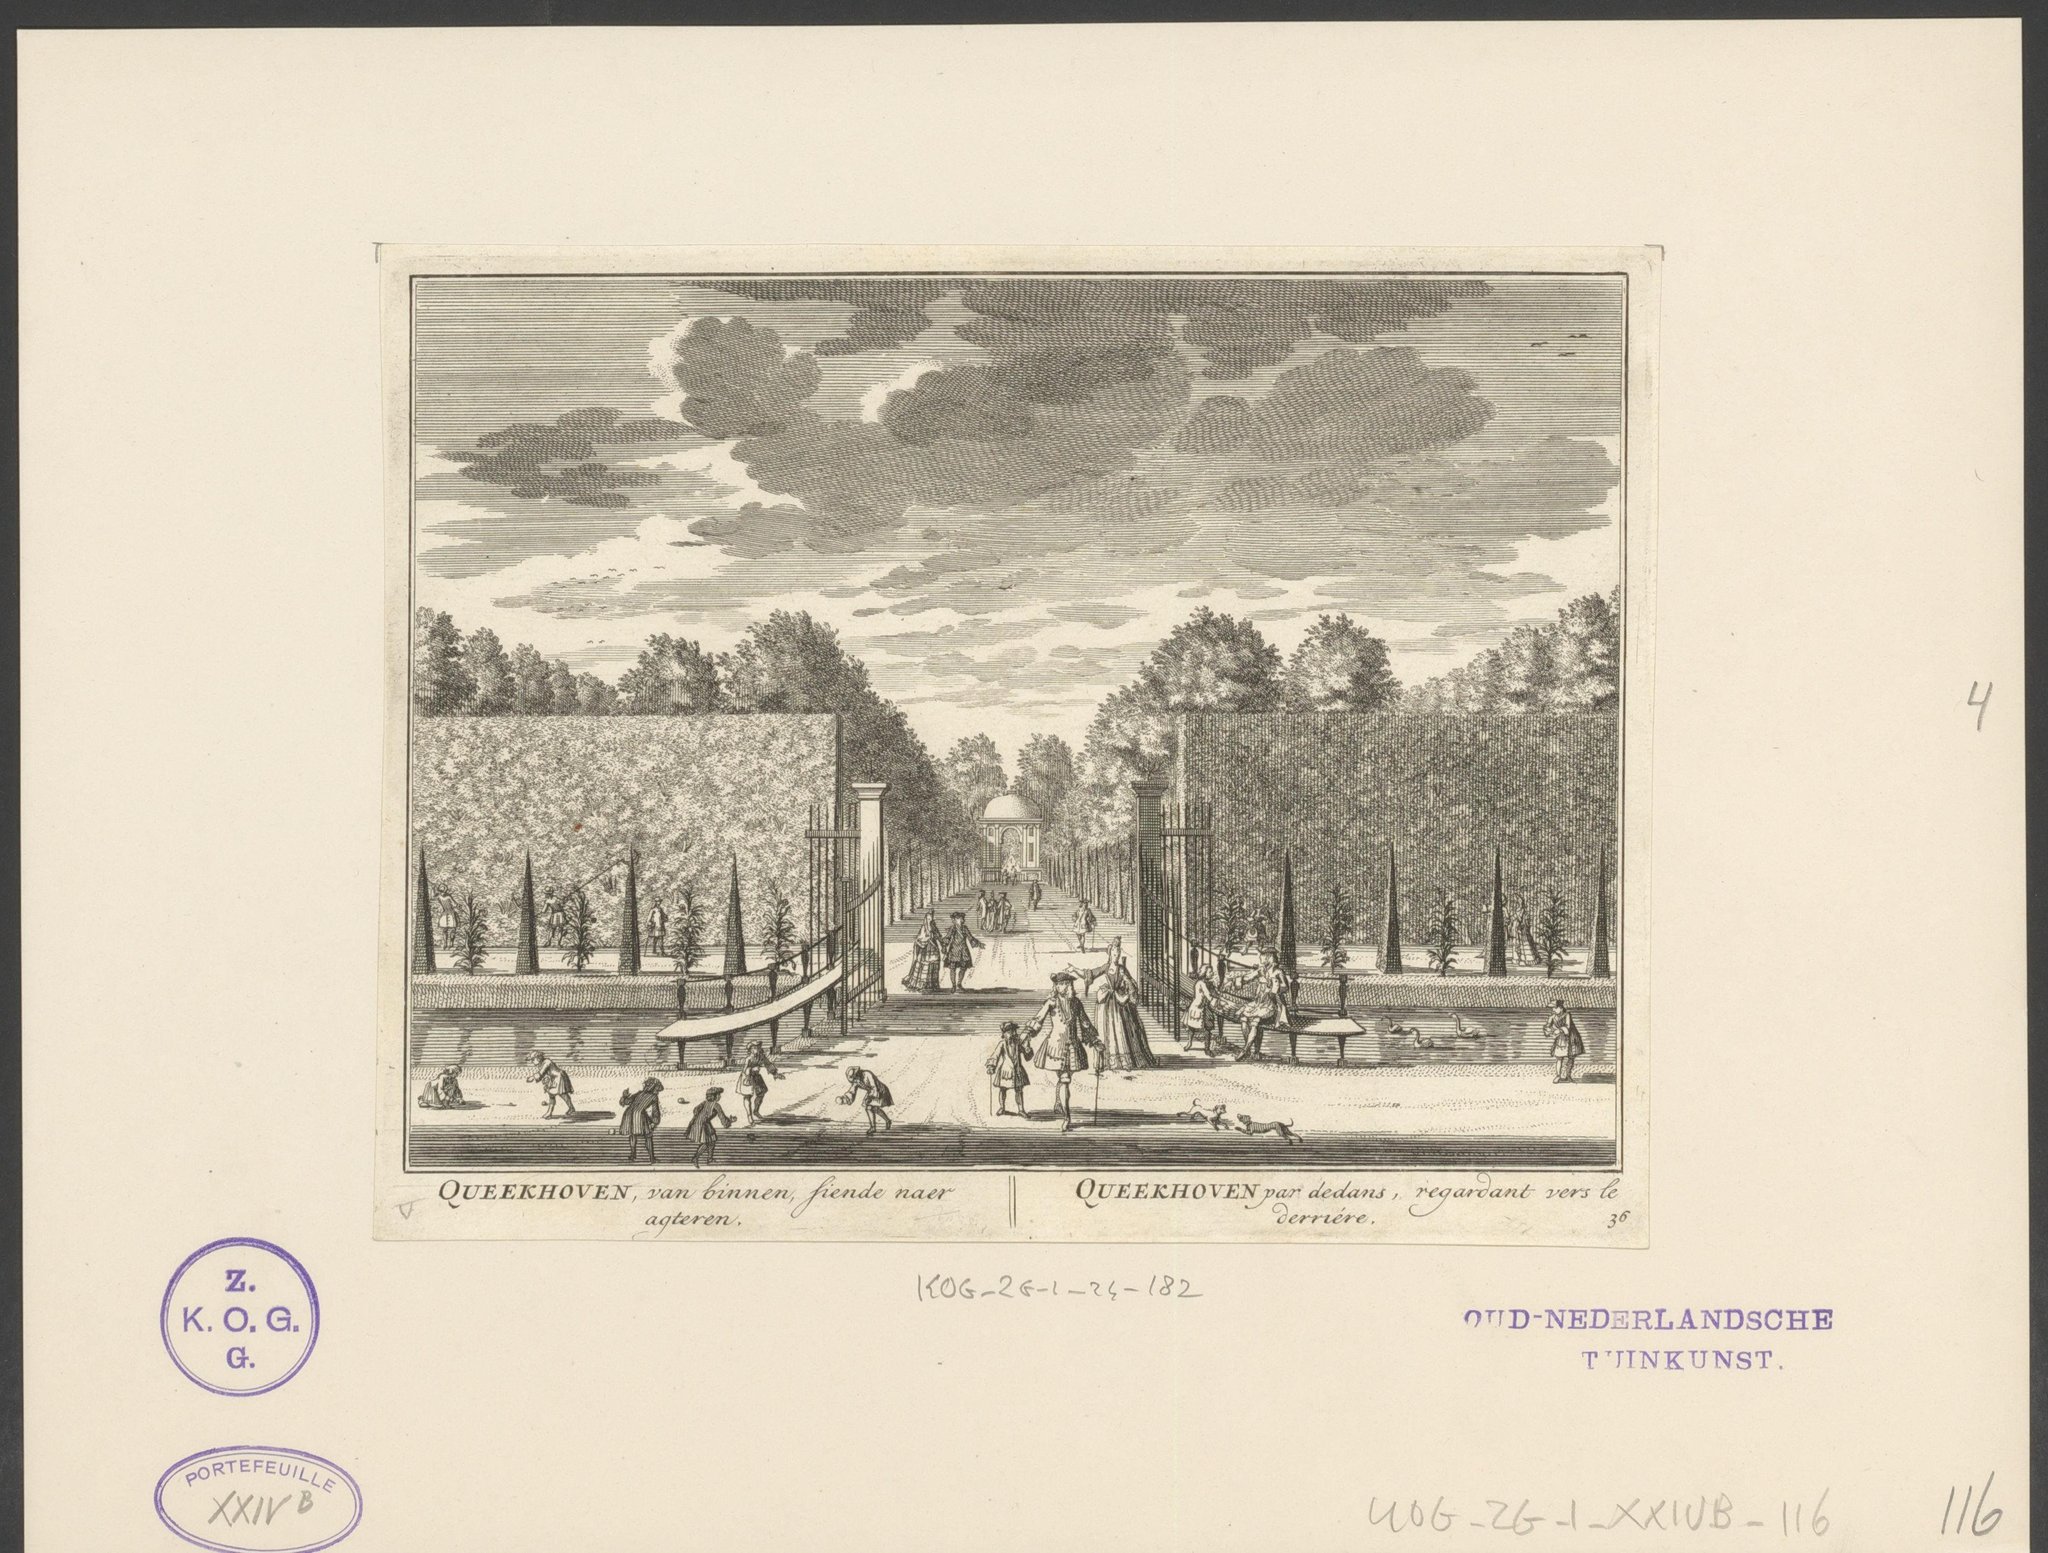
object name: print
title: Queekhoven, van binnen, siende naer agteren / Queekhoven par dedans, regardant vers le derriére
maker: hendrik de leth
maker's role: draughtsman, print maker, publisher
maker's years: 1703-1766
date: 1729-1732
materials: paper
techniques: engraving, etching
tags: french or architectonic garden; formal garden, forest path or lane, country-house, vecht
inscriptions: stamp, stamp, collector's mark: Lugt 1641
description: Prent mogelijk uit: Brouërius van Nidek, Matthaeus. Het zegepralend Kennemerland, vertoond in 100 heerlyke gezichten. Amsterdam: Jan Roman, s.a. Of uit: Brouërius van Nidek, Matthaeus. Het zegepralend Kennemerland, vertoond in veele heerlyke gezichten. Amsterdam: Andries en Hendrik de Leth, s.a [1729-1732]. Of uit: Brouërius van Nidek, Matthaeus. Het zegepralend Kennemerland, vertoond in veele heerlyke gezichten. Amsterdam: Jan Roman, s.a.